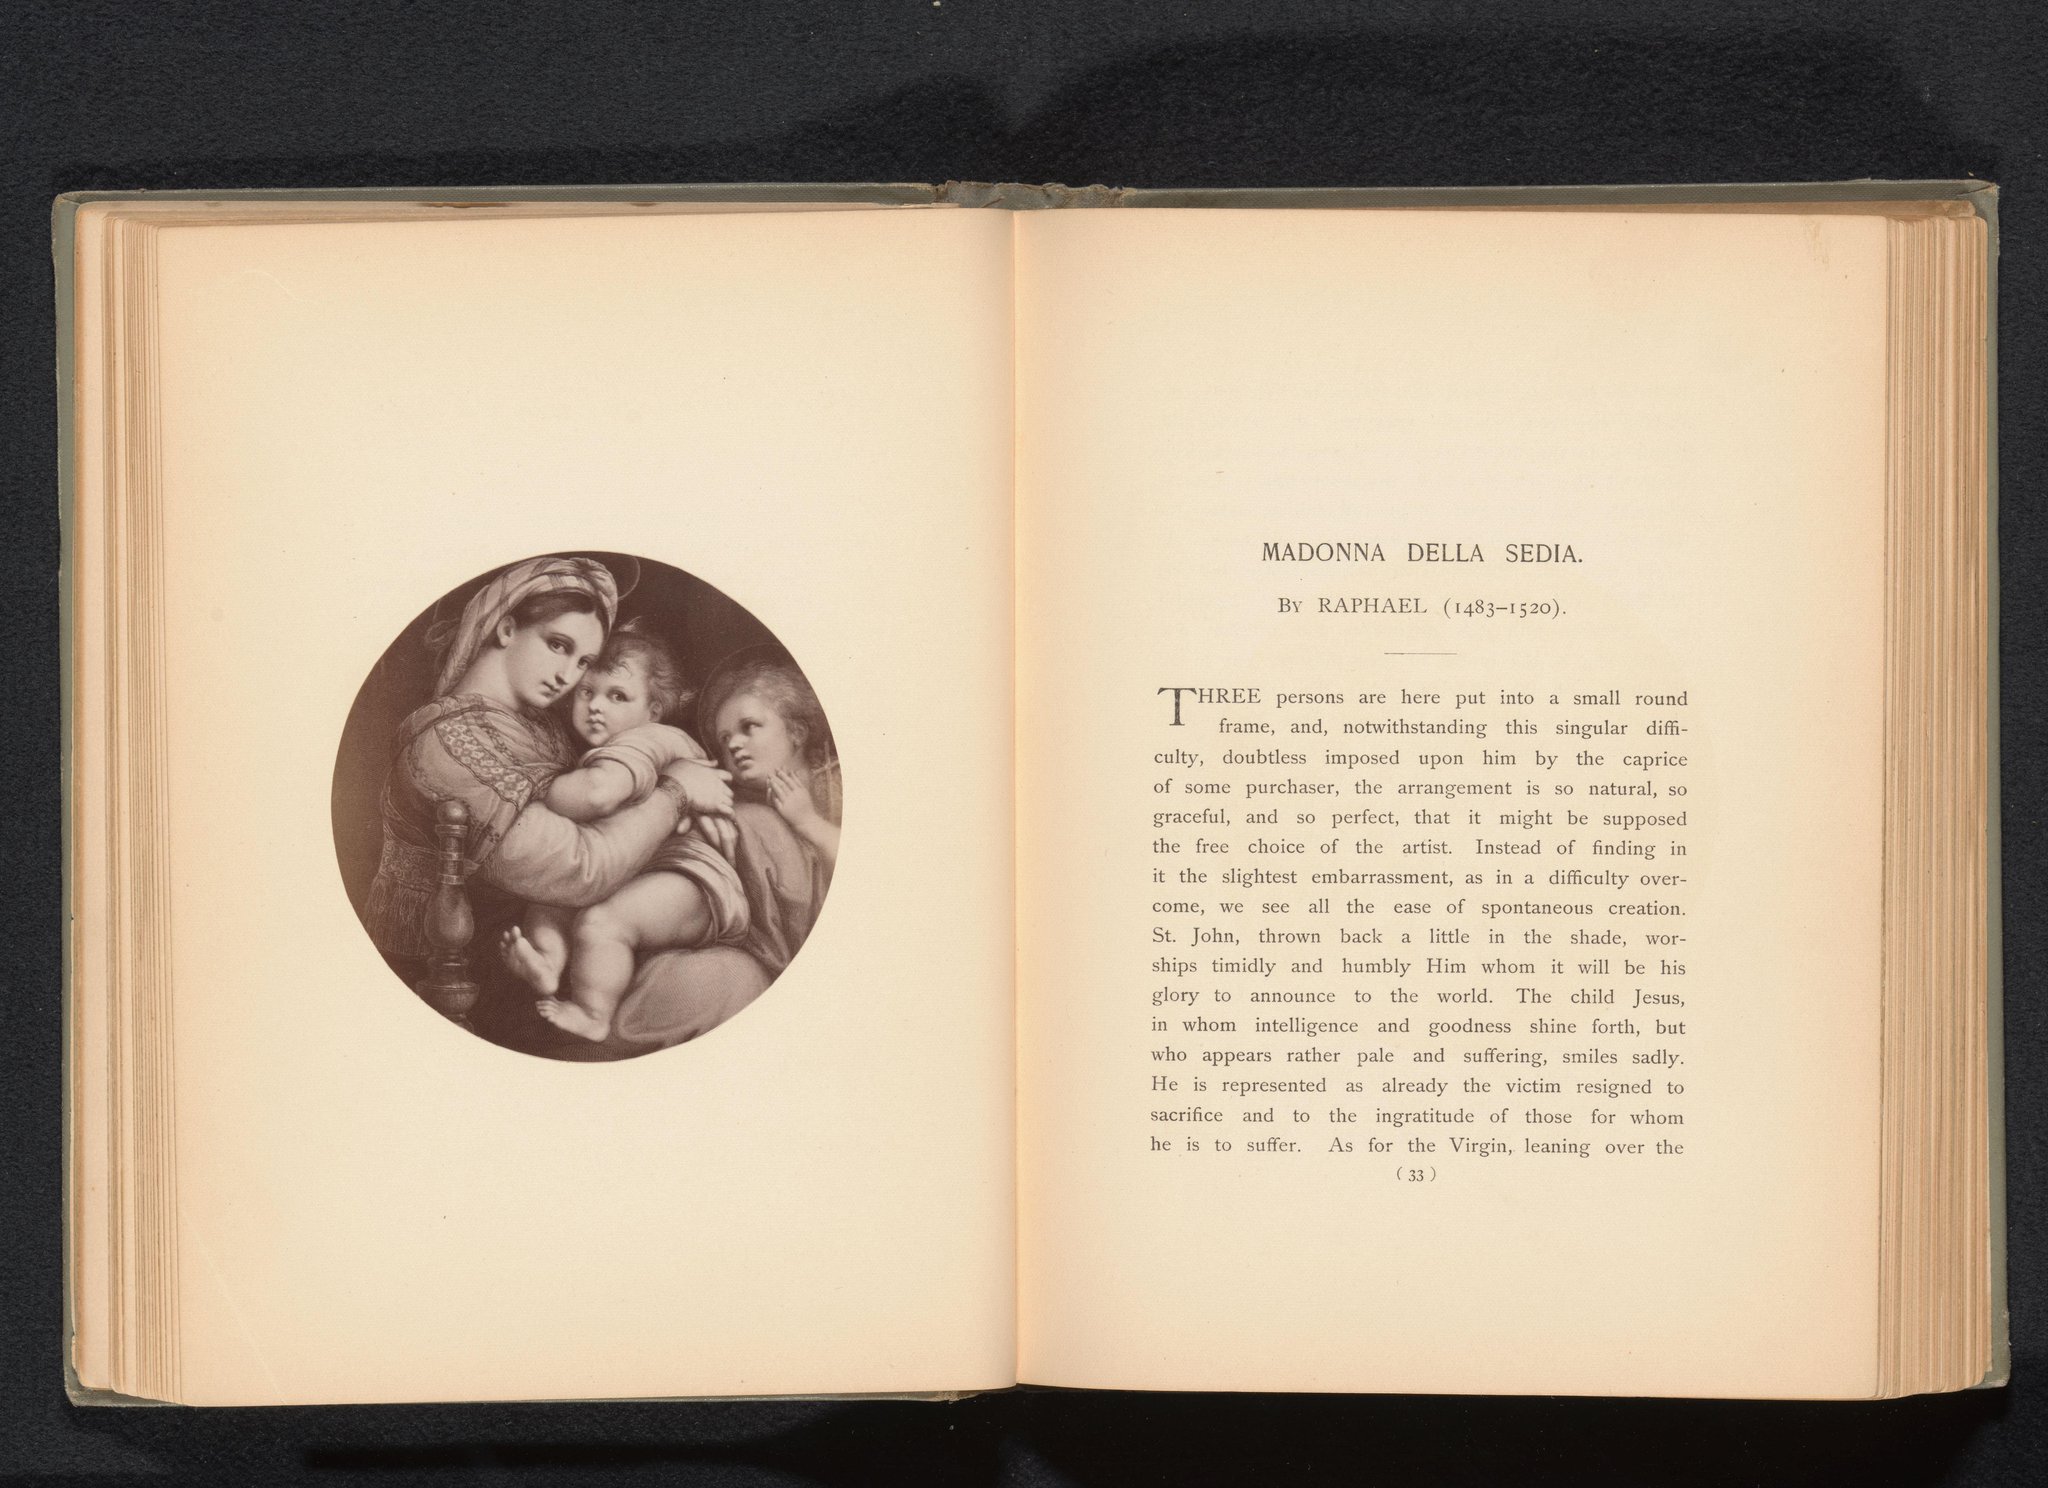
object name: photograph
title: Fotoreproductie van het schilderij Madonna met de stoel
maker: Anonymous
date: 1882-1887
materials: photographic support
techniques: albumen print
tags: madonna: i.e. mary with the christ-child